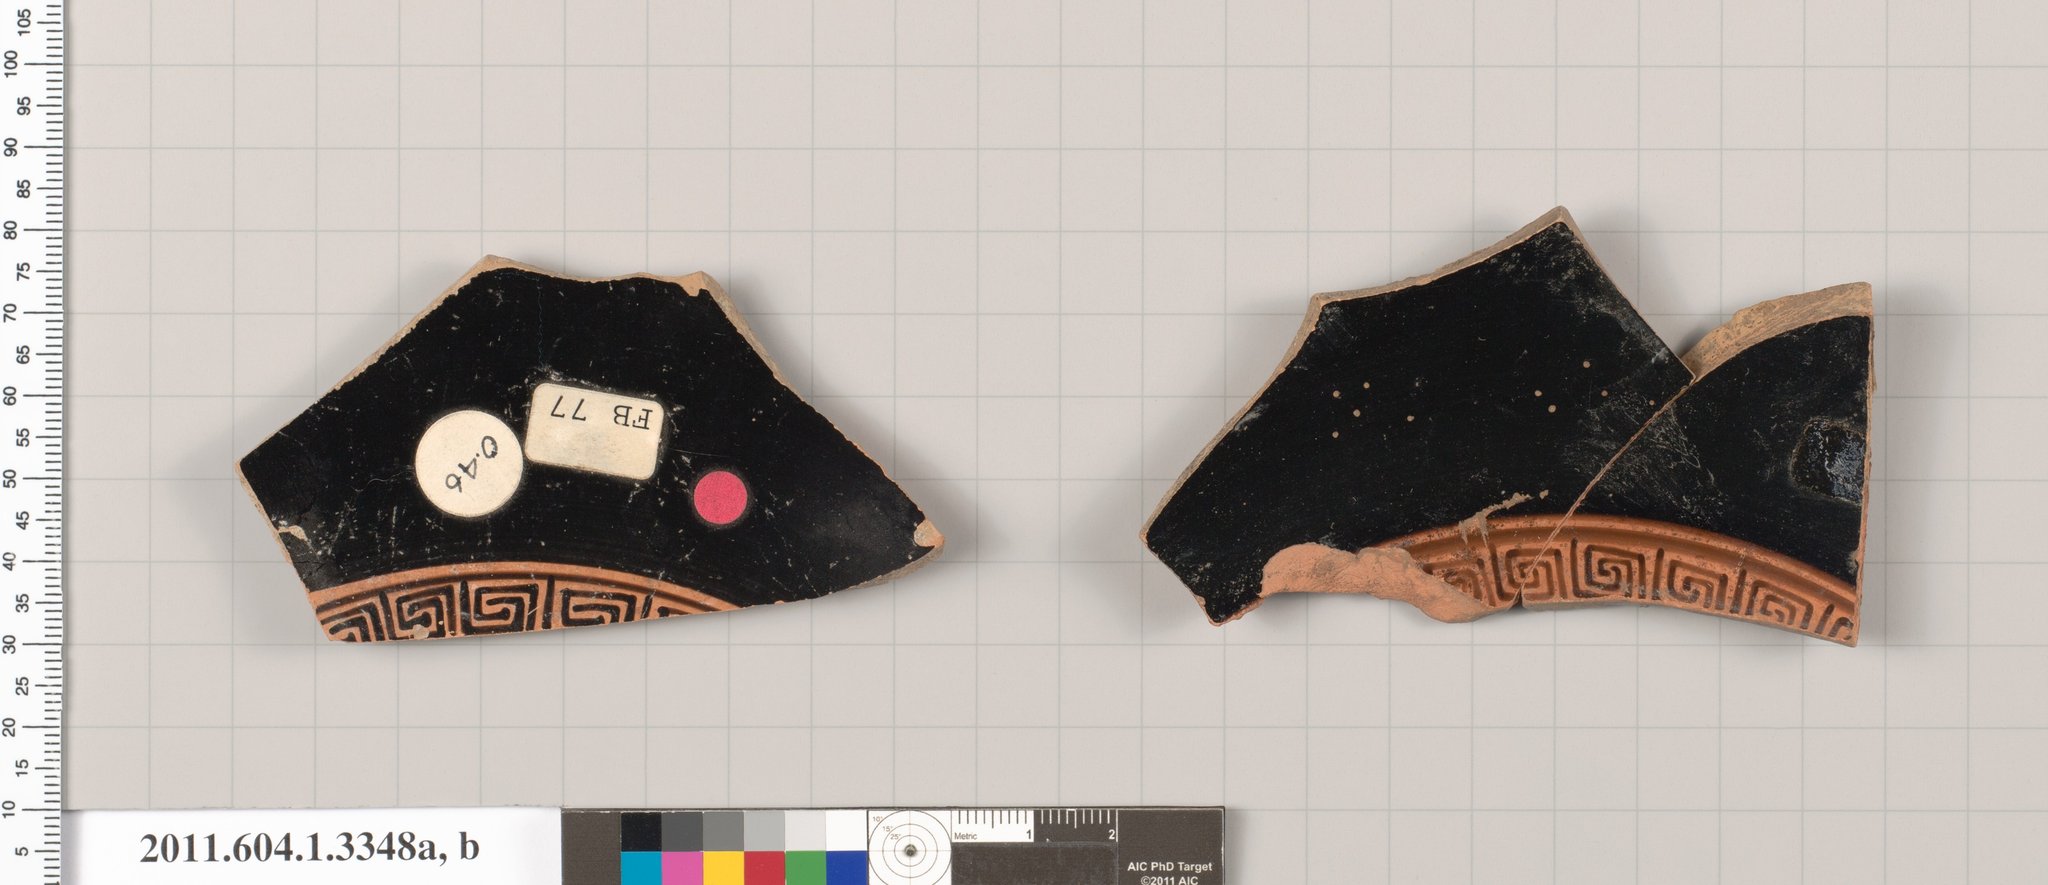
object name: kylix fragment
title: Terracotta fragments of kylikes (drinking cups)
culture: greek, attic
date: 500-470 BCE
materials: terracotta